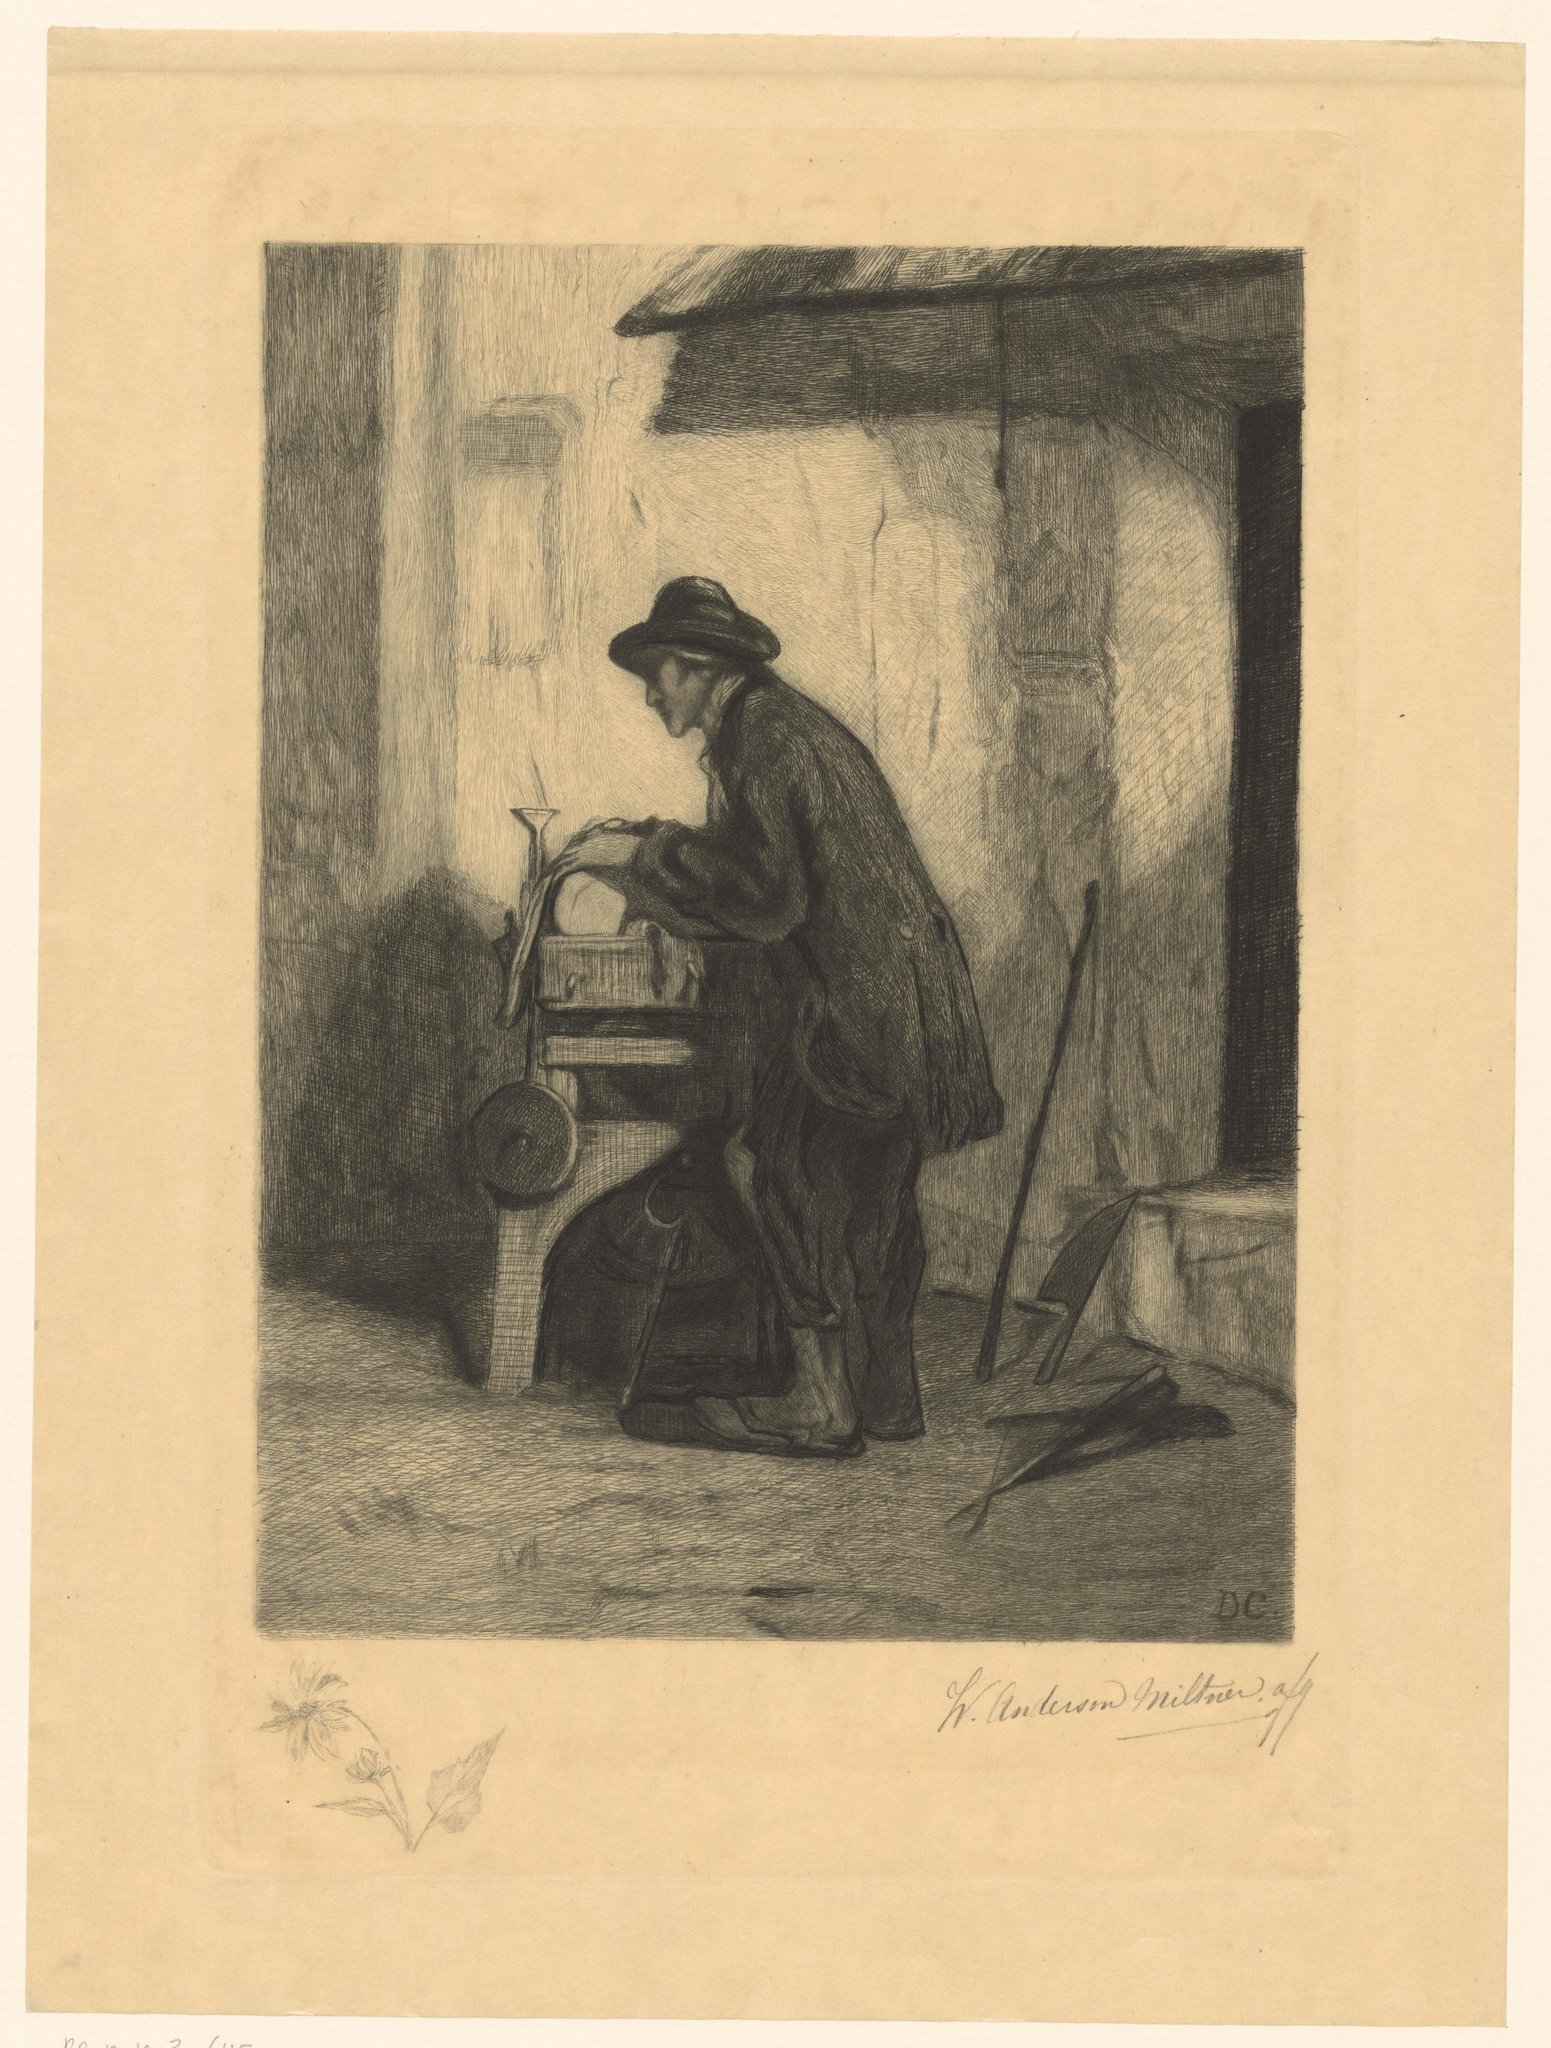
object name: print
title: Scharenslijper aan het werk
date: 1877-1913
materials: paper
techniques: etching, intaglio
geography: netherlands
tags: sharpening, grinding (industrial processes), tools, aids, implements ~ crafts and industries: scissors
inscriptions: collector's mark: Lugt 2233